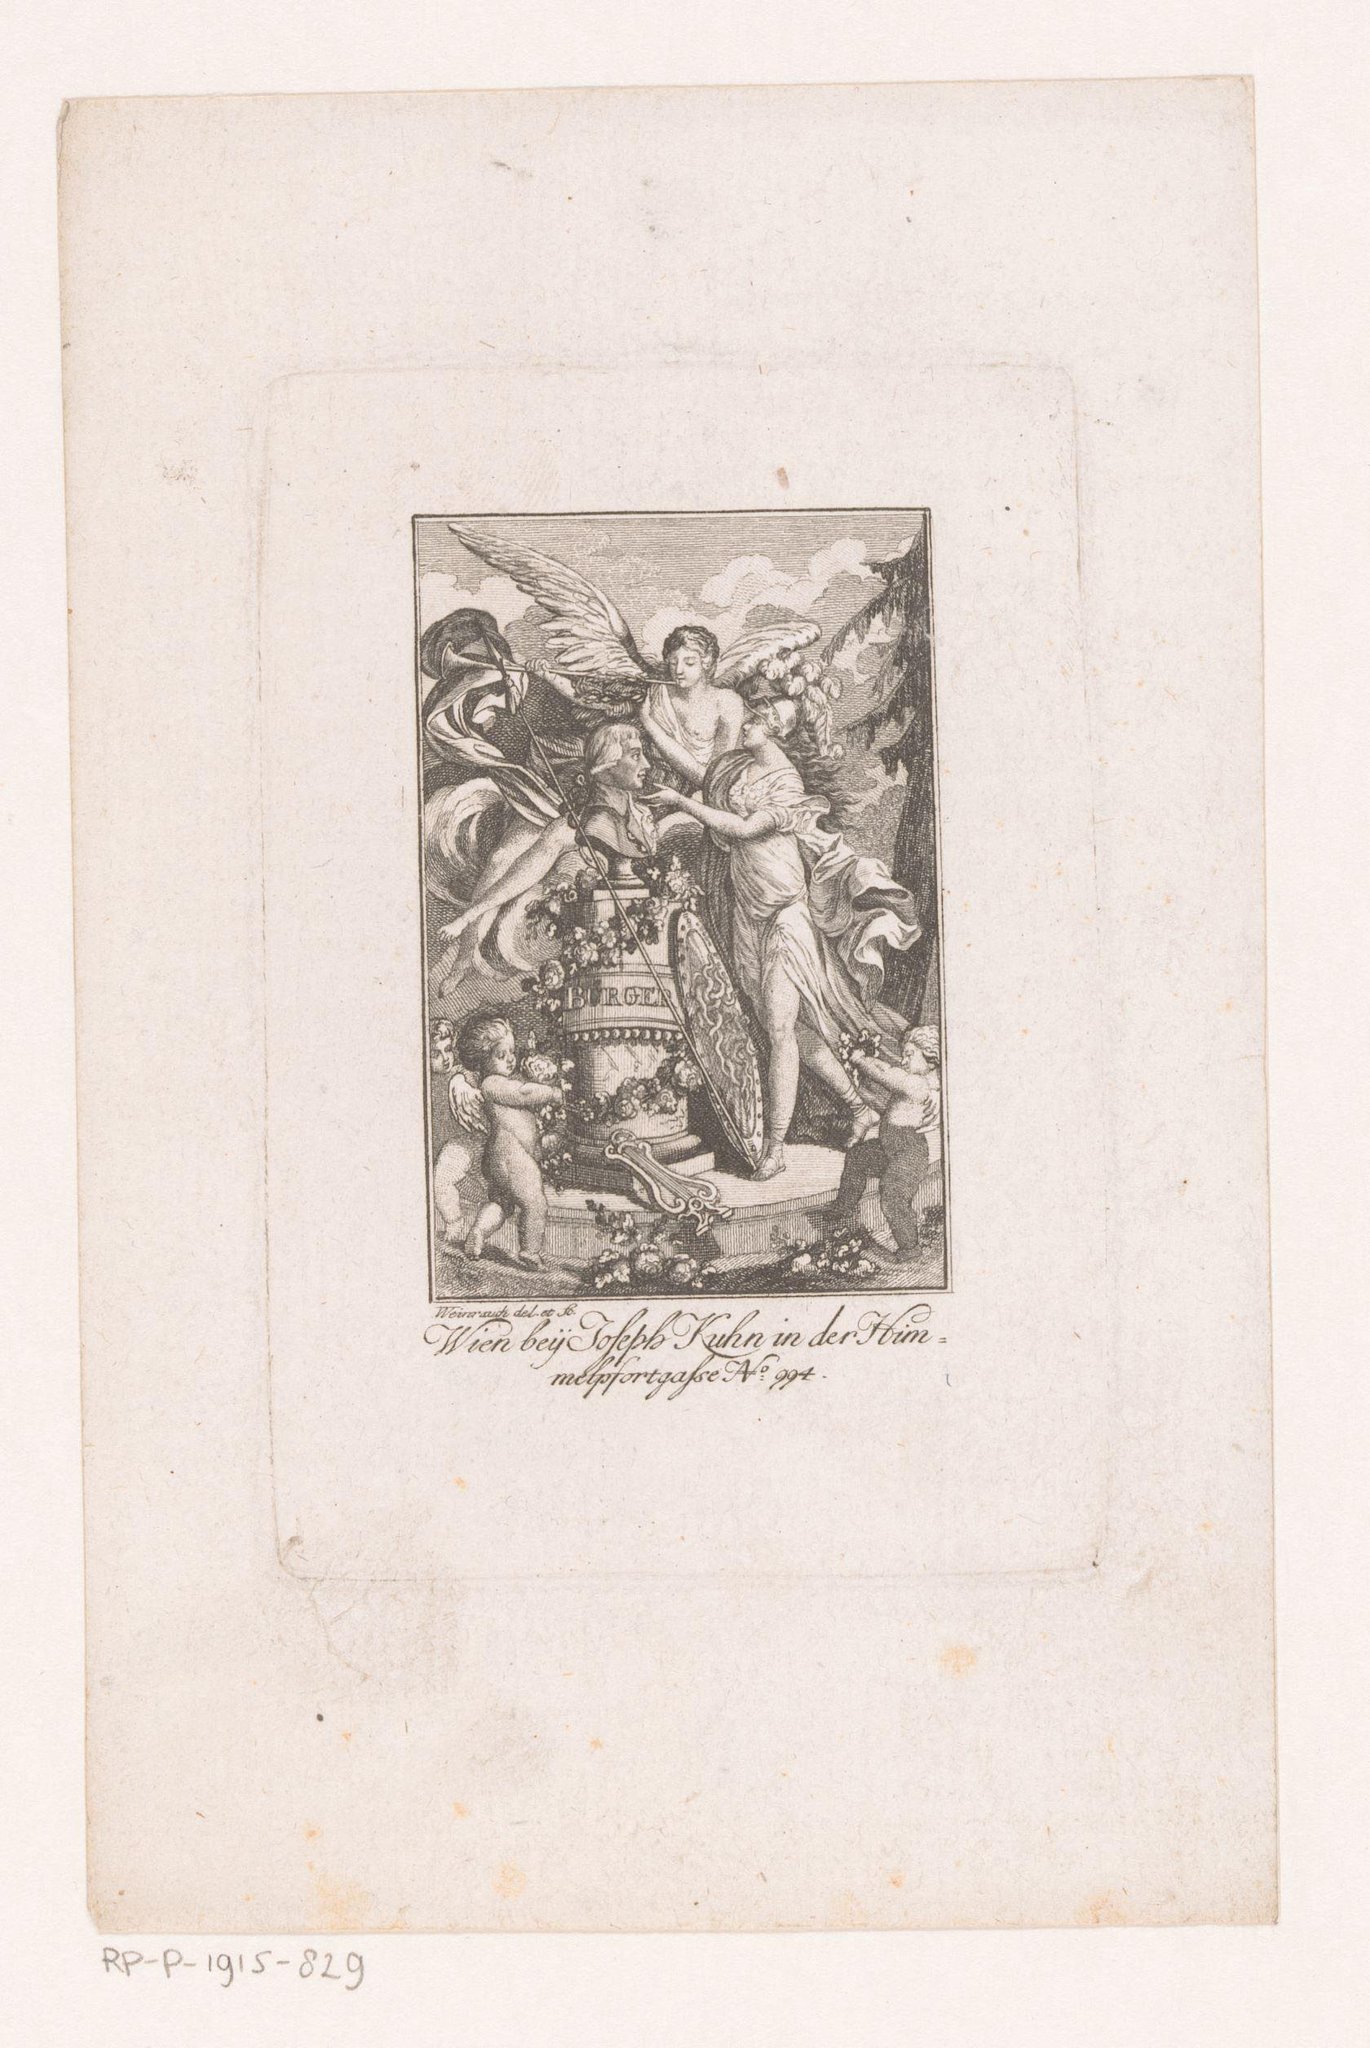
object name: print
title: Minerva bij portretbuste van een man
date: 1775-1846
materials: paper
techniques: etching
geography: vienna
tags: (story of) minerva (pallas, athena), historical persons, piece of sculpture, reproduction of a piece of sculpture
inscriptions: collector's mark: Lugt 2228